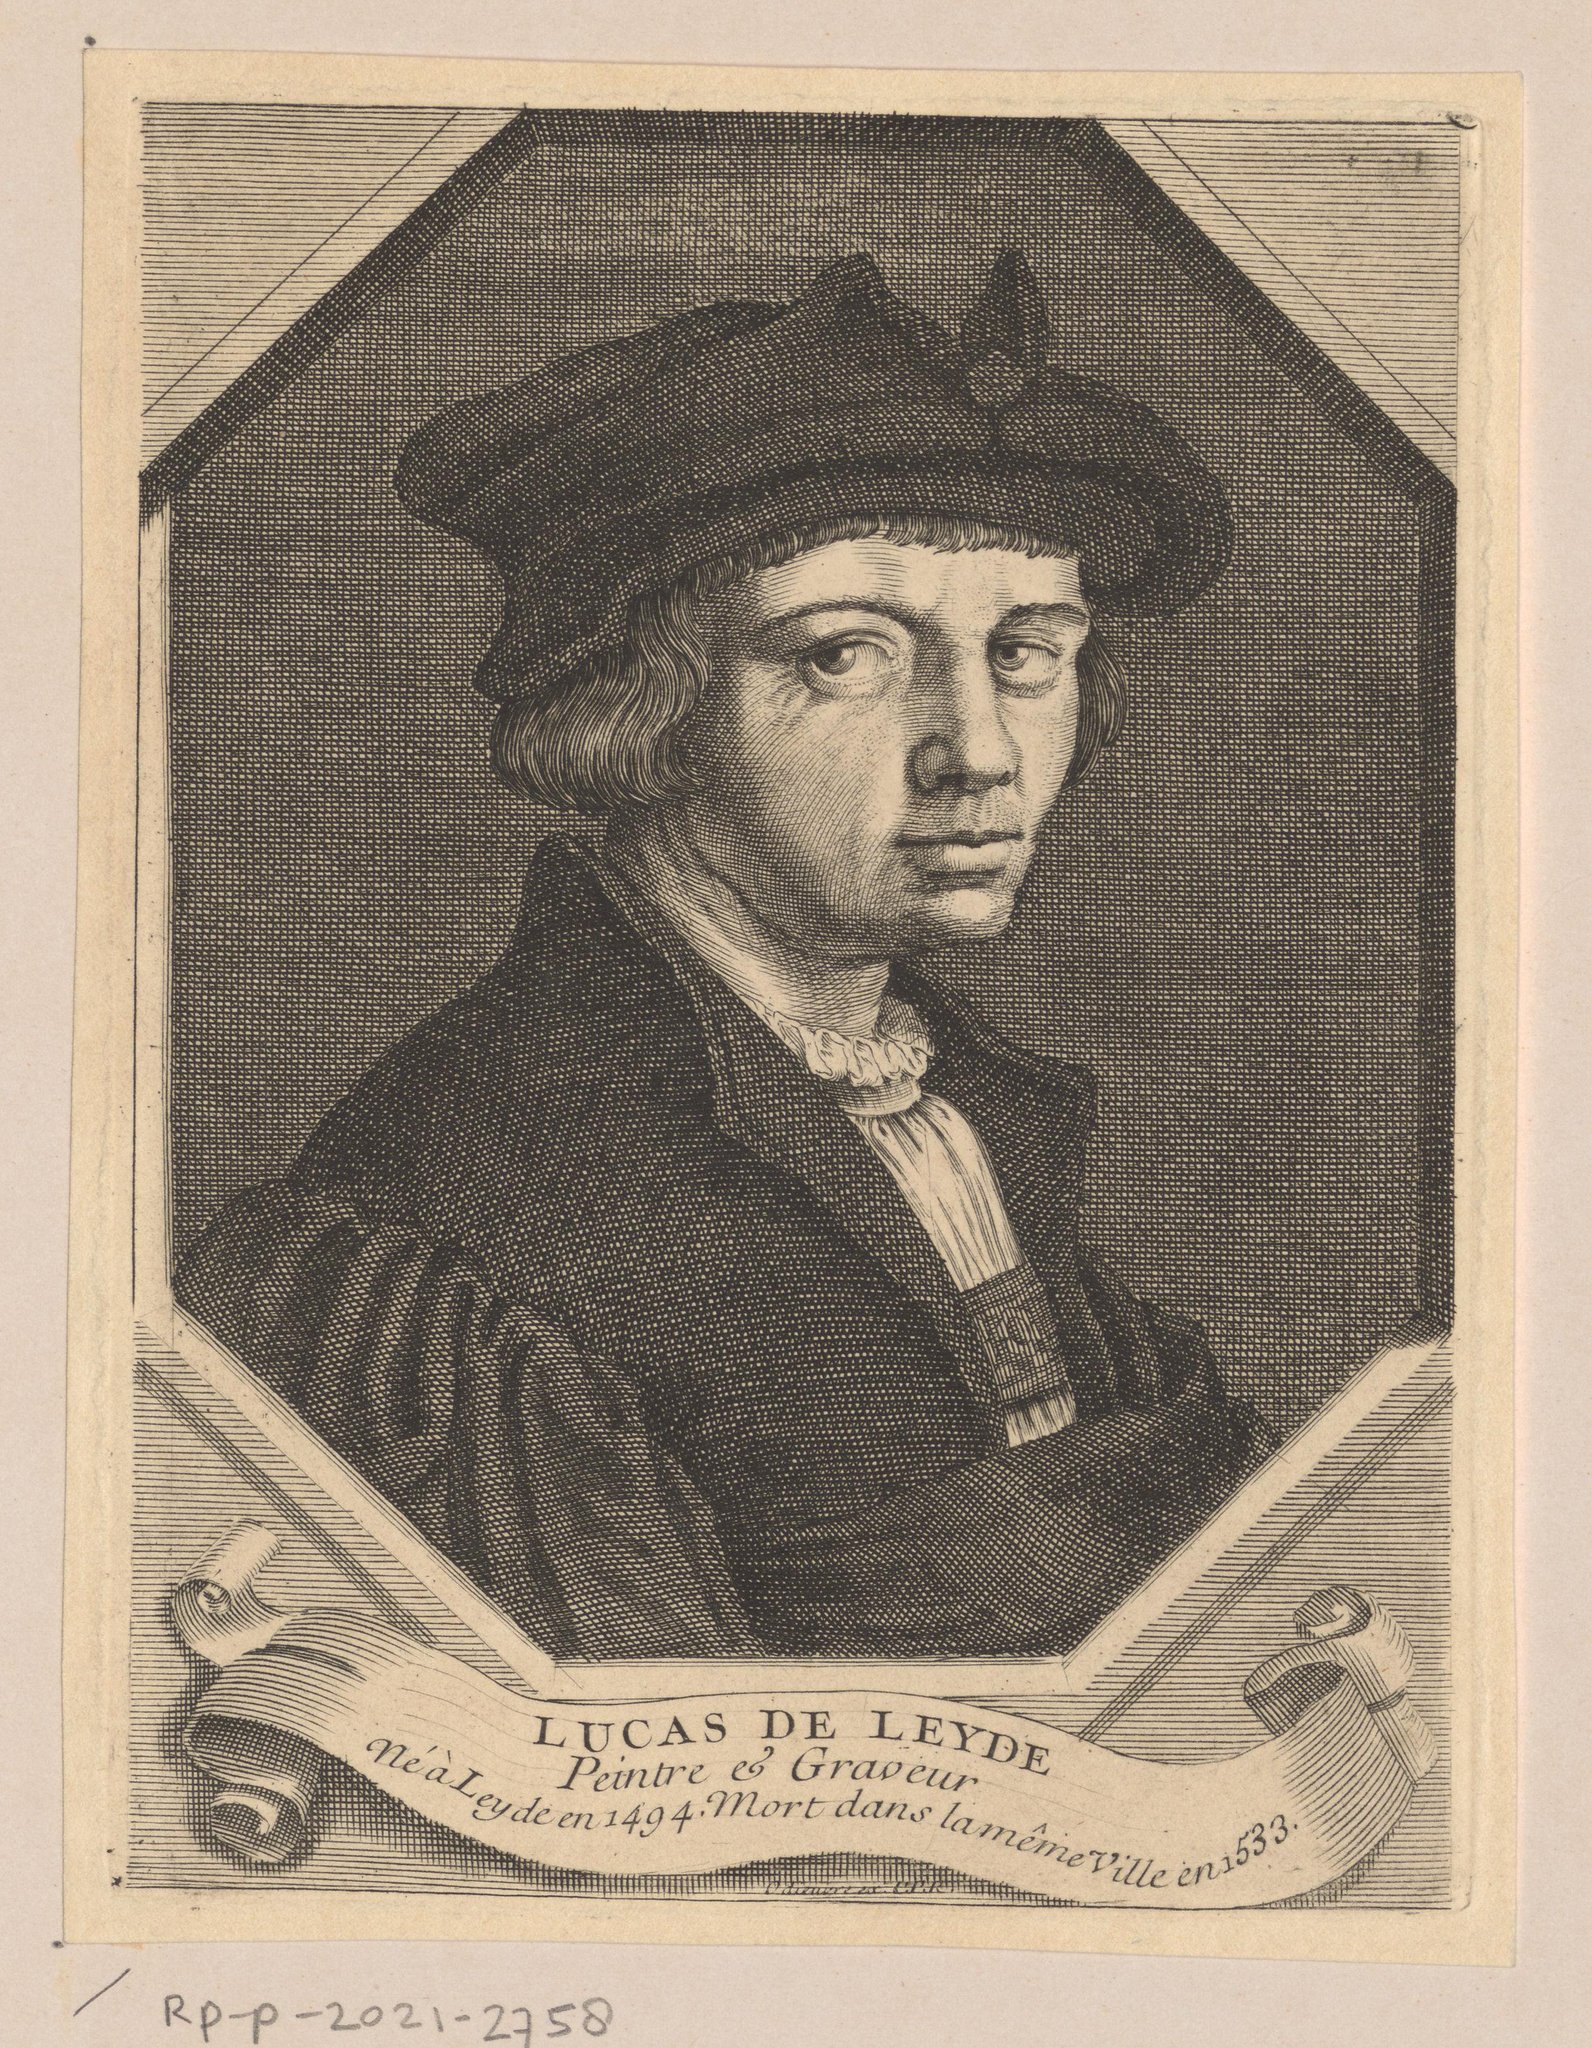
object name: print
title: Portret van Lucas van Leyden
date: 1714-1756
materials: paper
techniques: engraving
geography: paris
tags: leiden, painter, print maker, draughtsman, lucas van leyden, historical persons, head-gear: hat, portrait, self-portrait of painter, portrait, self-portrait of graphic artist